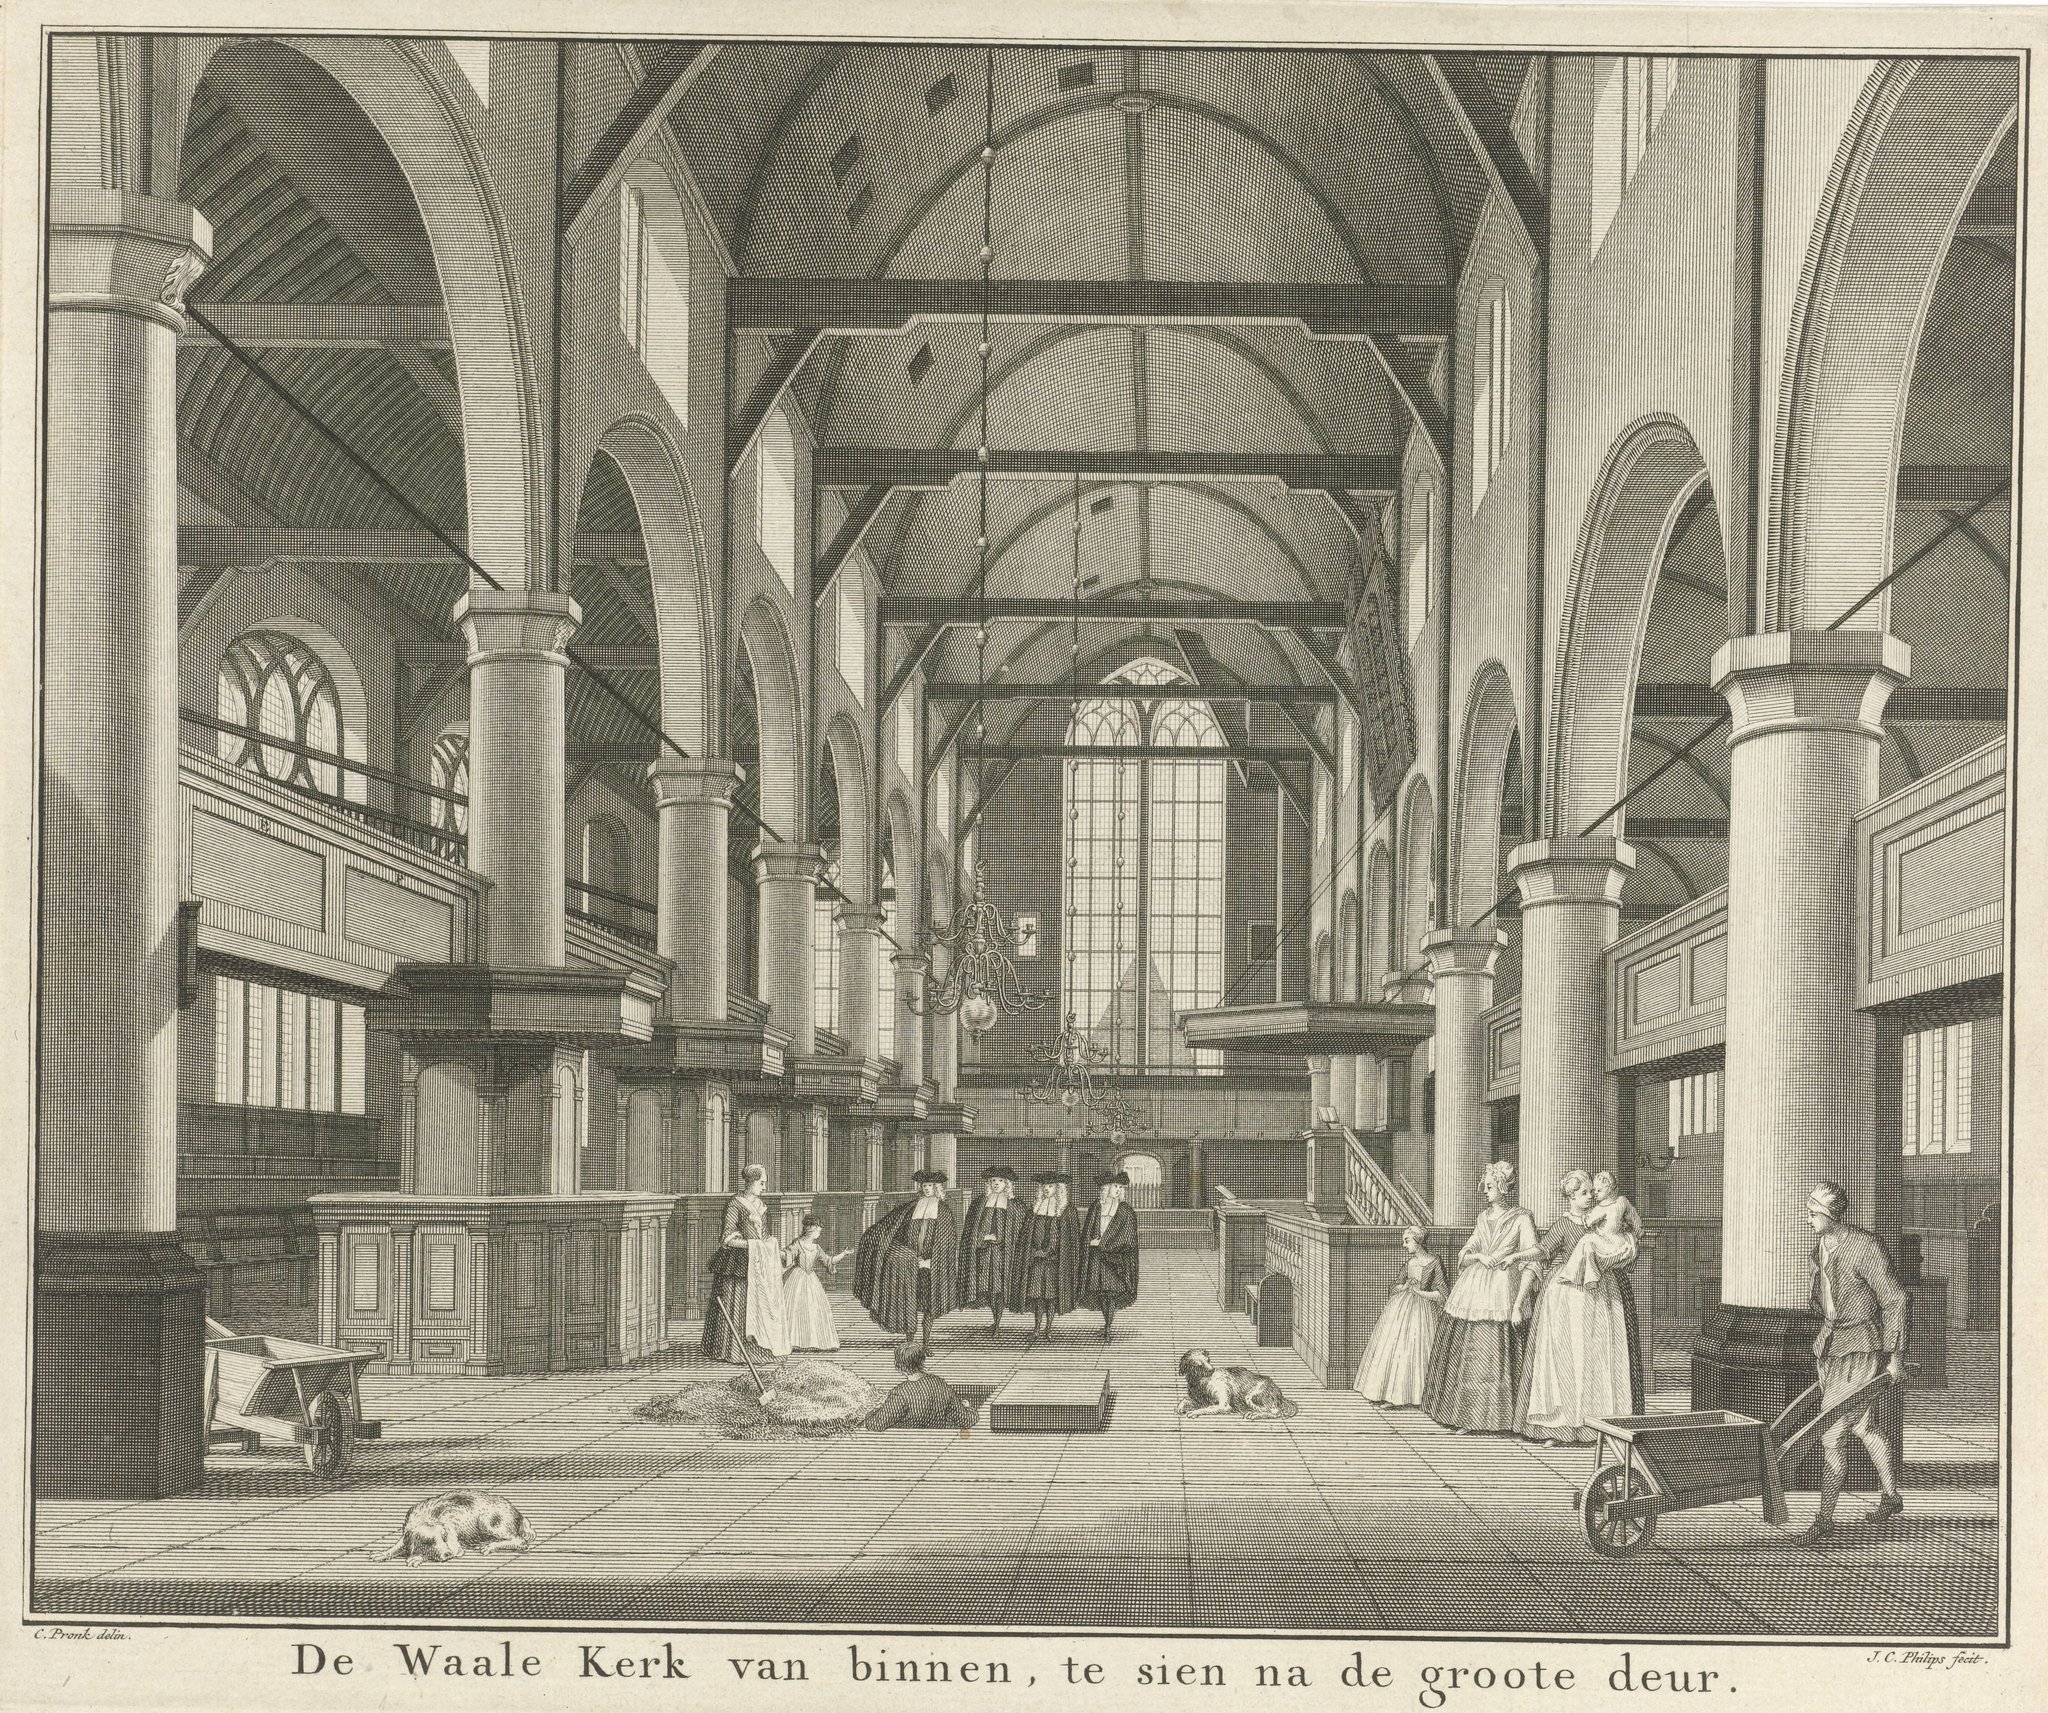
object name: print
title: Interieur van de Waalse Kerk te Amsterdam, gezien richting de hoofdingang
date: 1730-1759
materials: paper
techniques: engraving, etching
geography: amsterdam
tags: burial, interior of church, funerary ceremonial, grave digger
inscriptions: collector's mark: Lugt 2228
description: Interieur van de Waalse Kerk te Amsterdam, gezien richting de hoofdingang. In de kerk is een begrafenis van een kind gaande. Het kistje wordt gedragen door een van de vier mannen in het zwart.